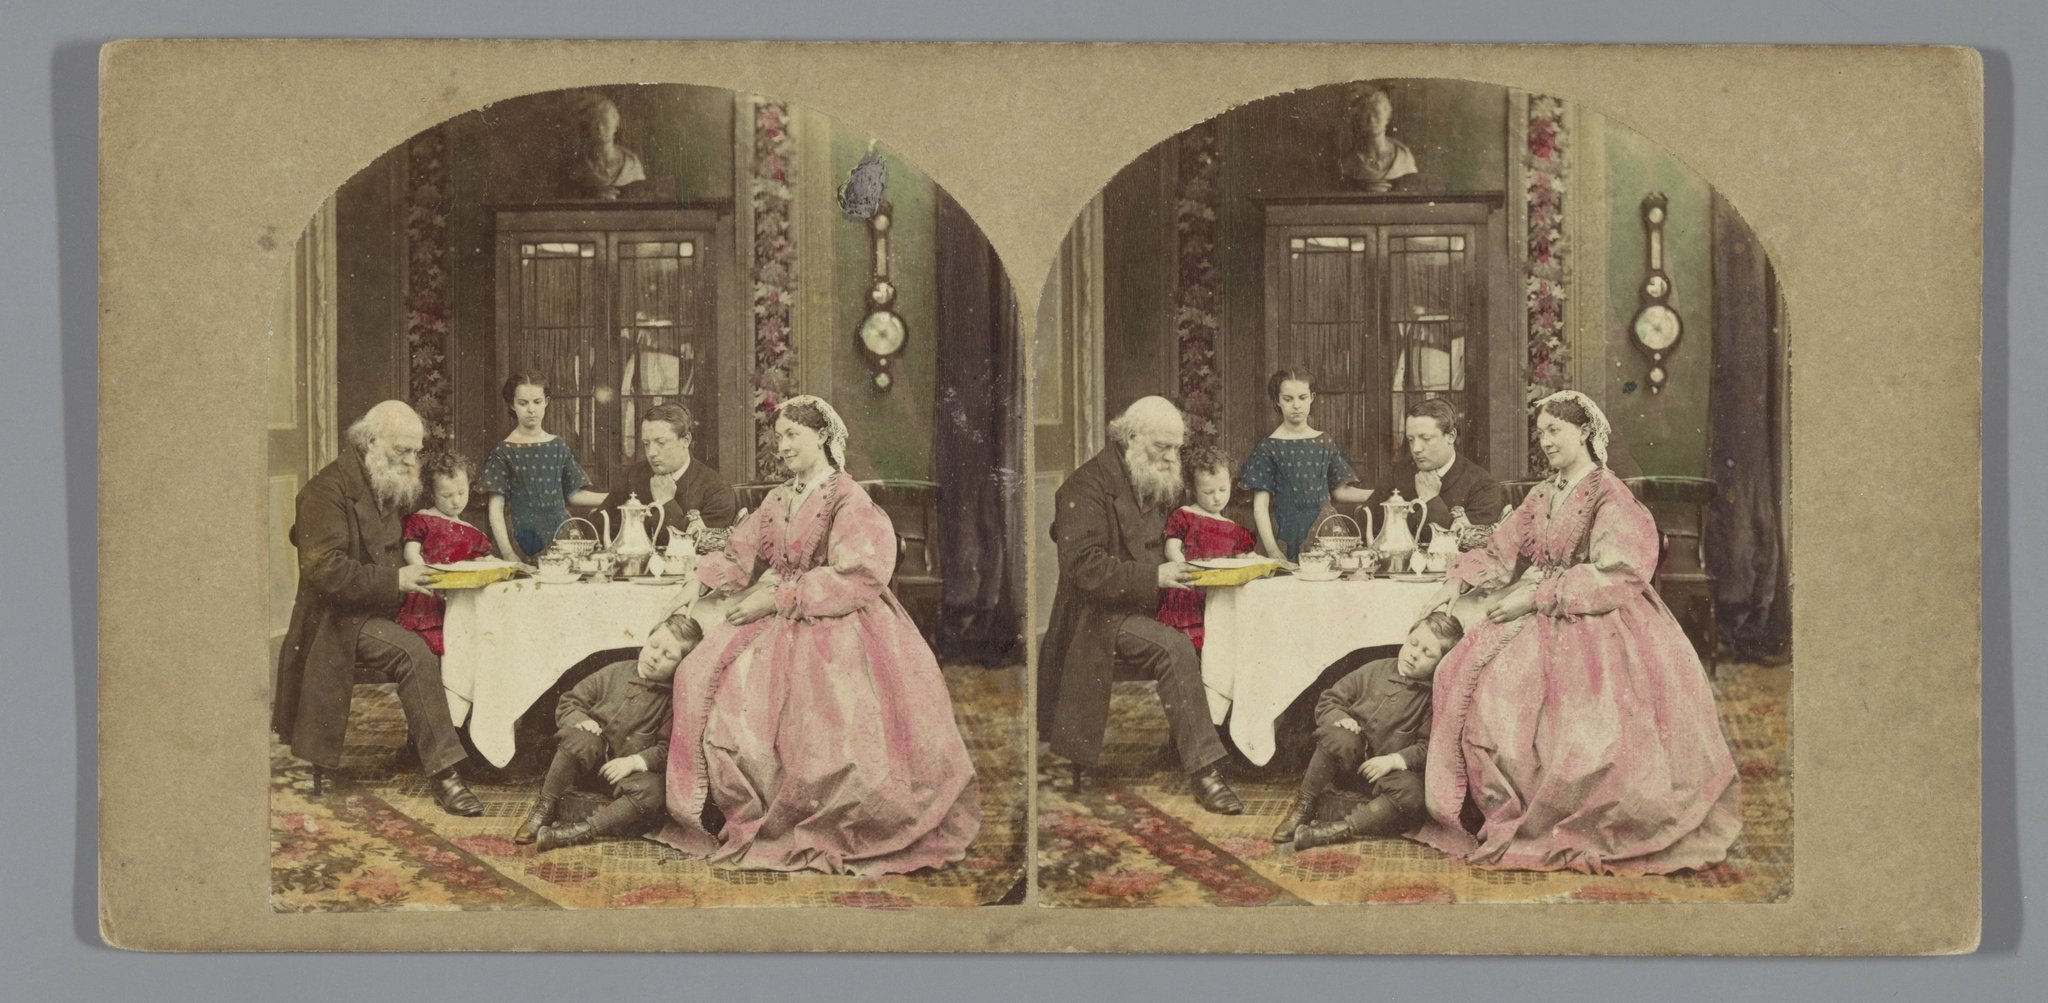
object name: stereograph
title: Morning Prayers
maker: Anonymous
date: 1852-1863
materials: cardboard, paper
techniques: albumen print, hand coloring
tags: family, descendance, prayer at table, saying grace, dining-room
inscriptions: inscription: ‘P’, copyright notice: ‘Copyright.’